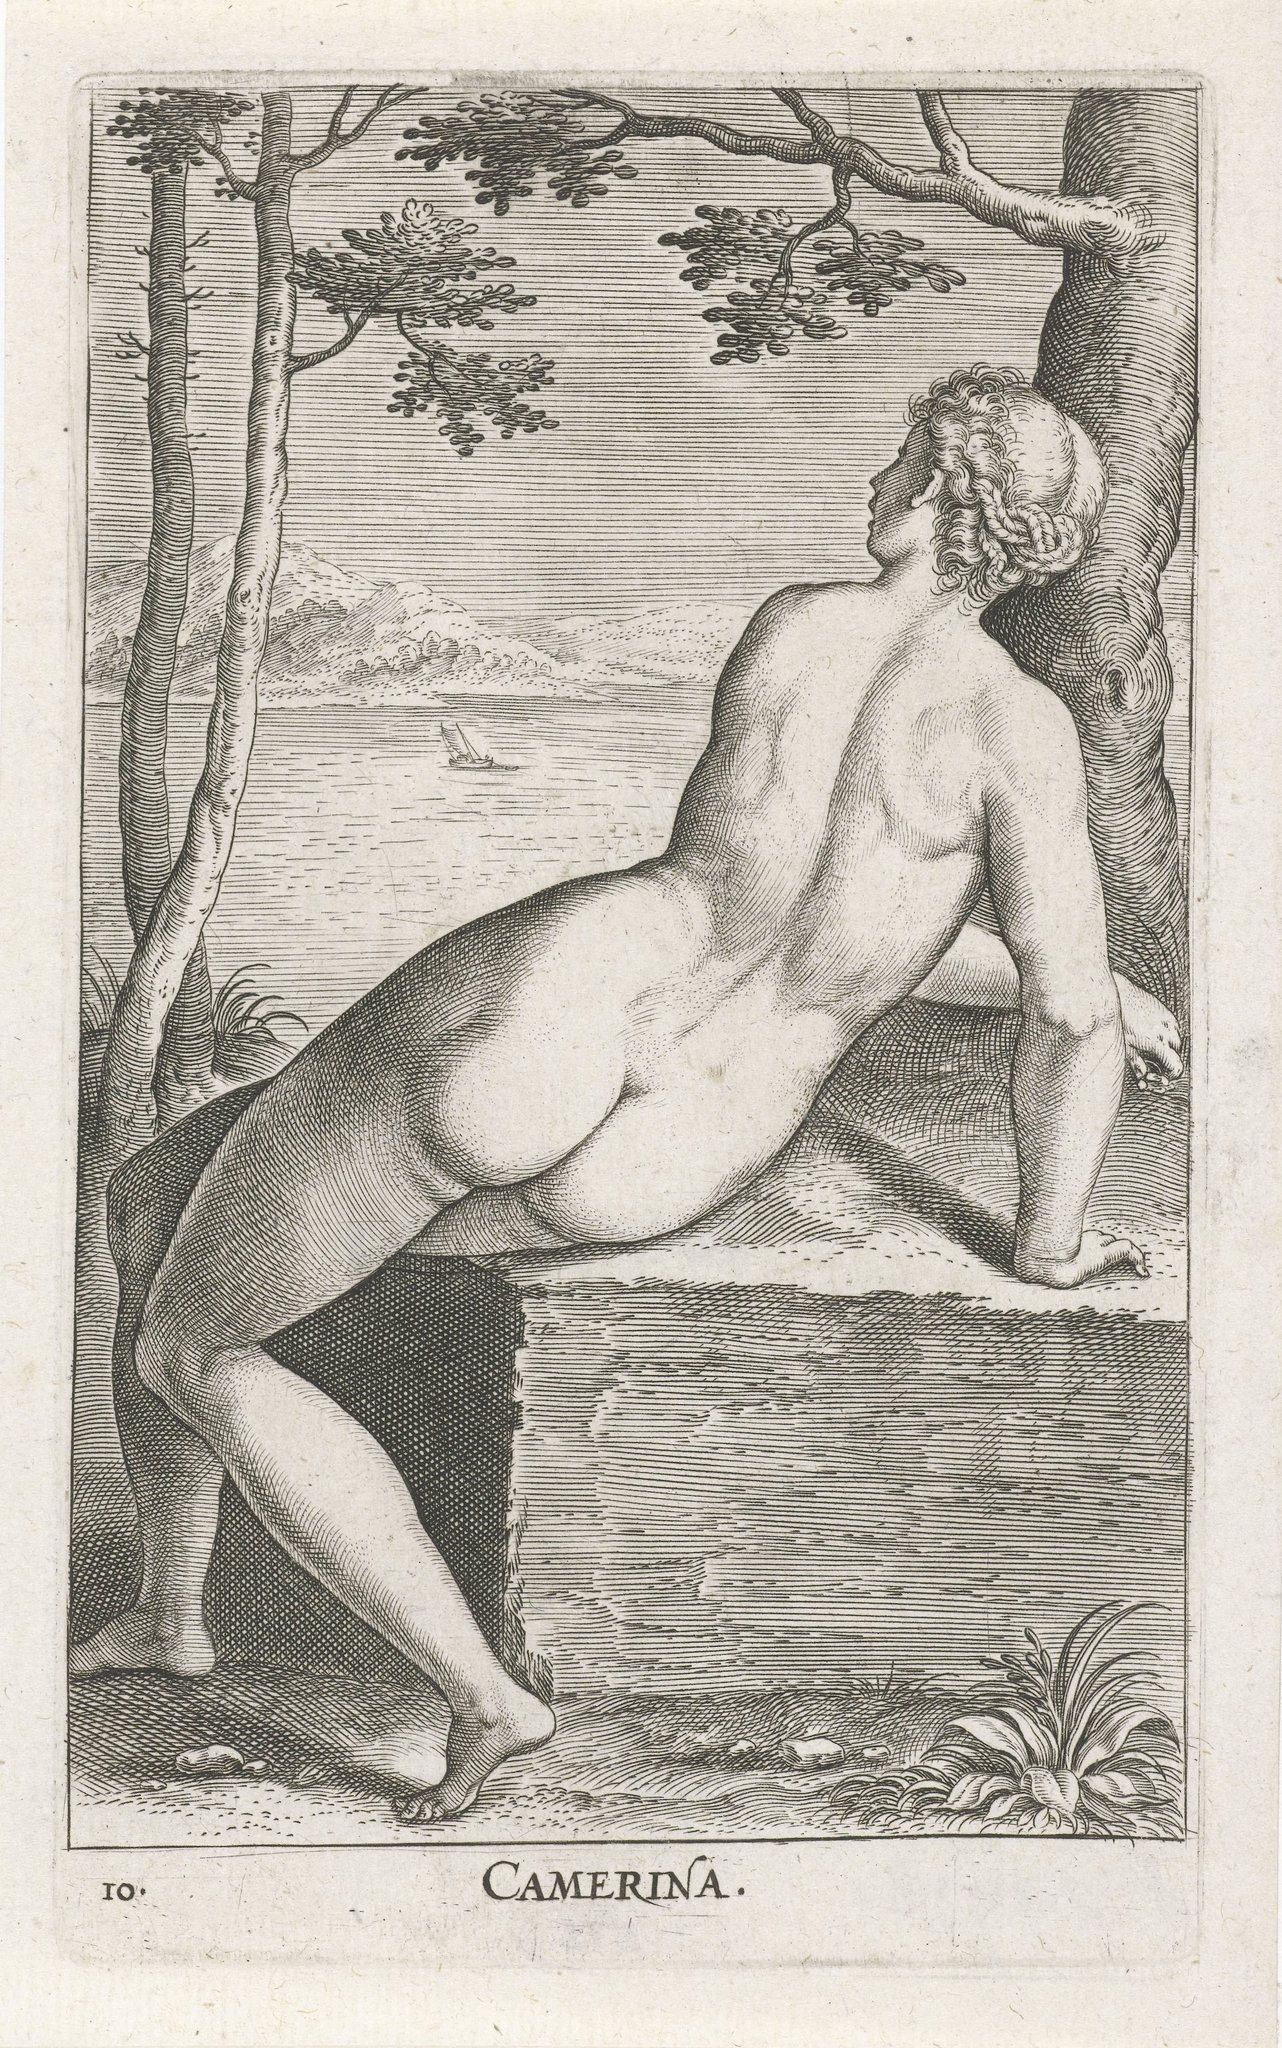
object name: print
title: Stroom- en waternimfen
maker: philips galle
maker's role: print maker, publisher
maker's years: 1537-1612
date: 1587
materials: paper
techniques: engraving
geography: antwerp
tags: other nereids (or sea-nymphs) (with name)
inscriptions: collector's mark: Lugt 2228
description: De waternimf Camerina, gezeten op een stenen blok. De prent maakt deel uit van een zeventiendelige serie over stroom- en waternimfen.